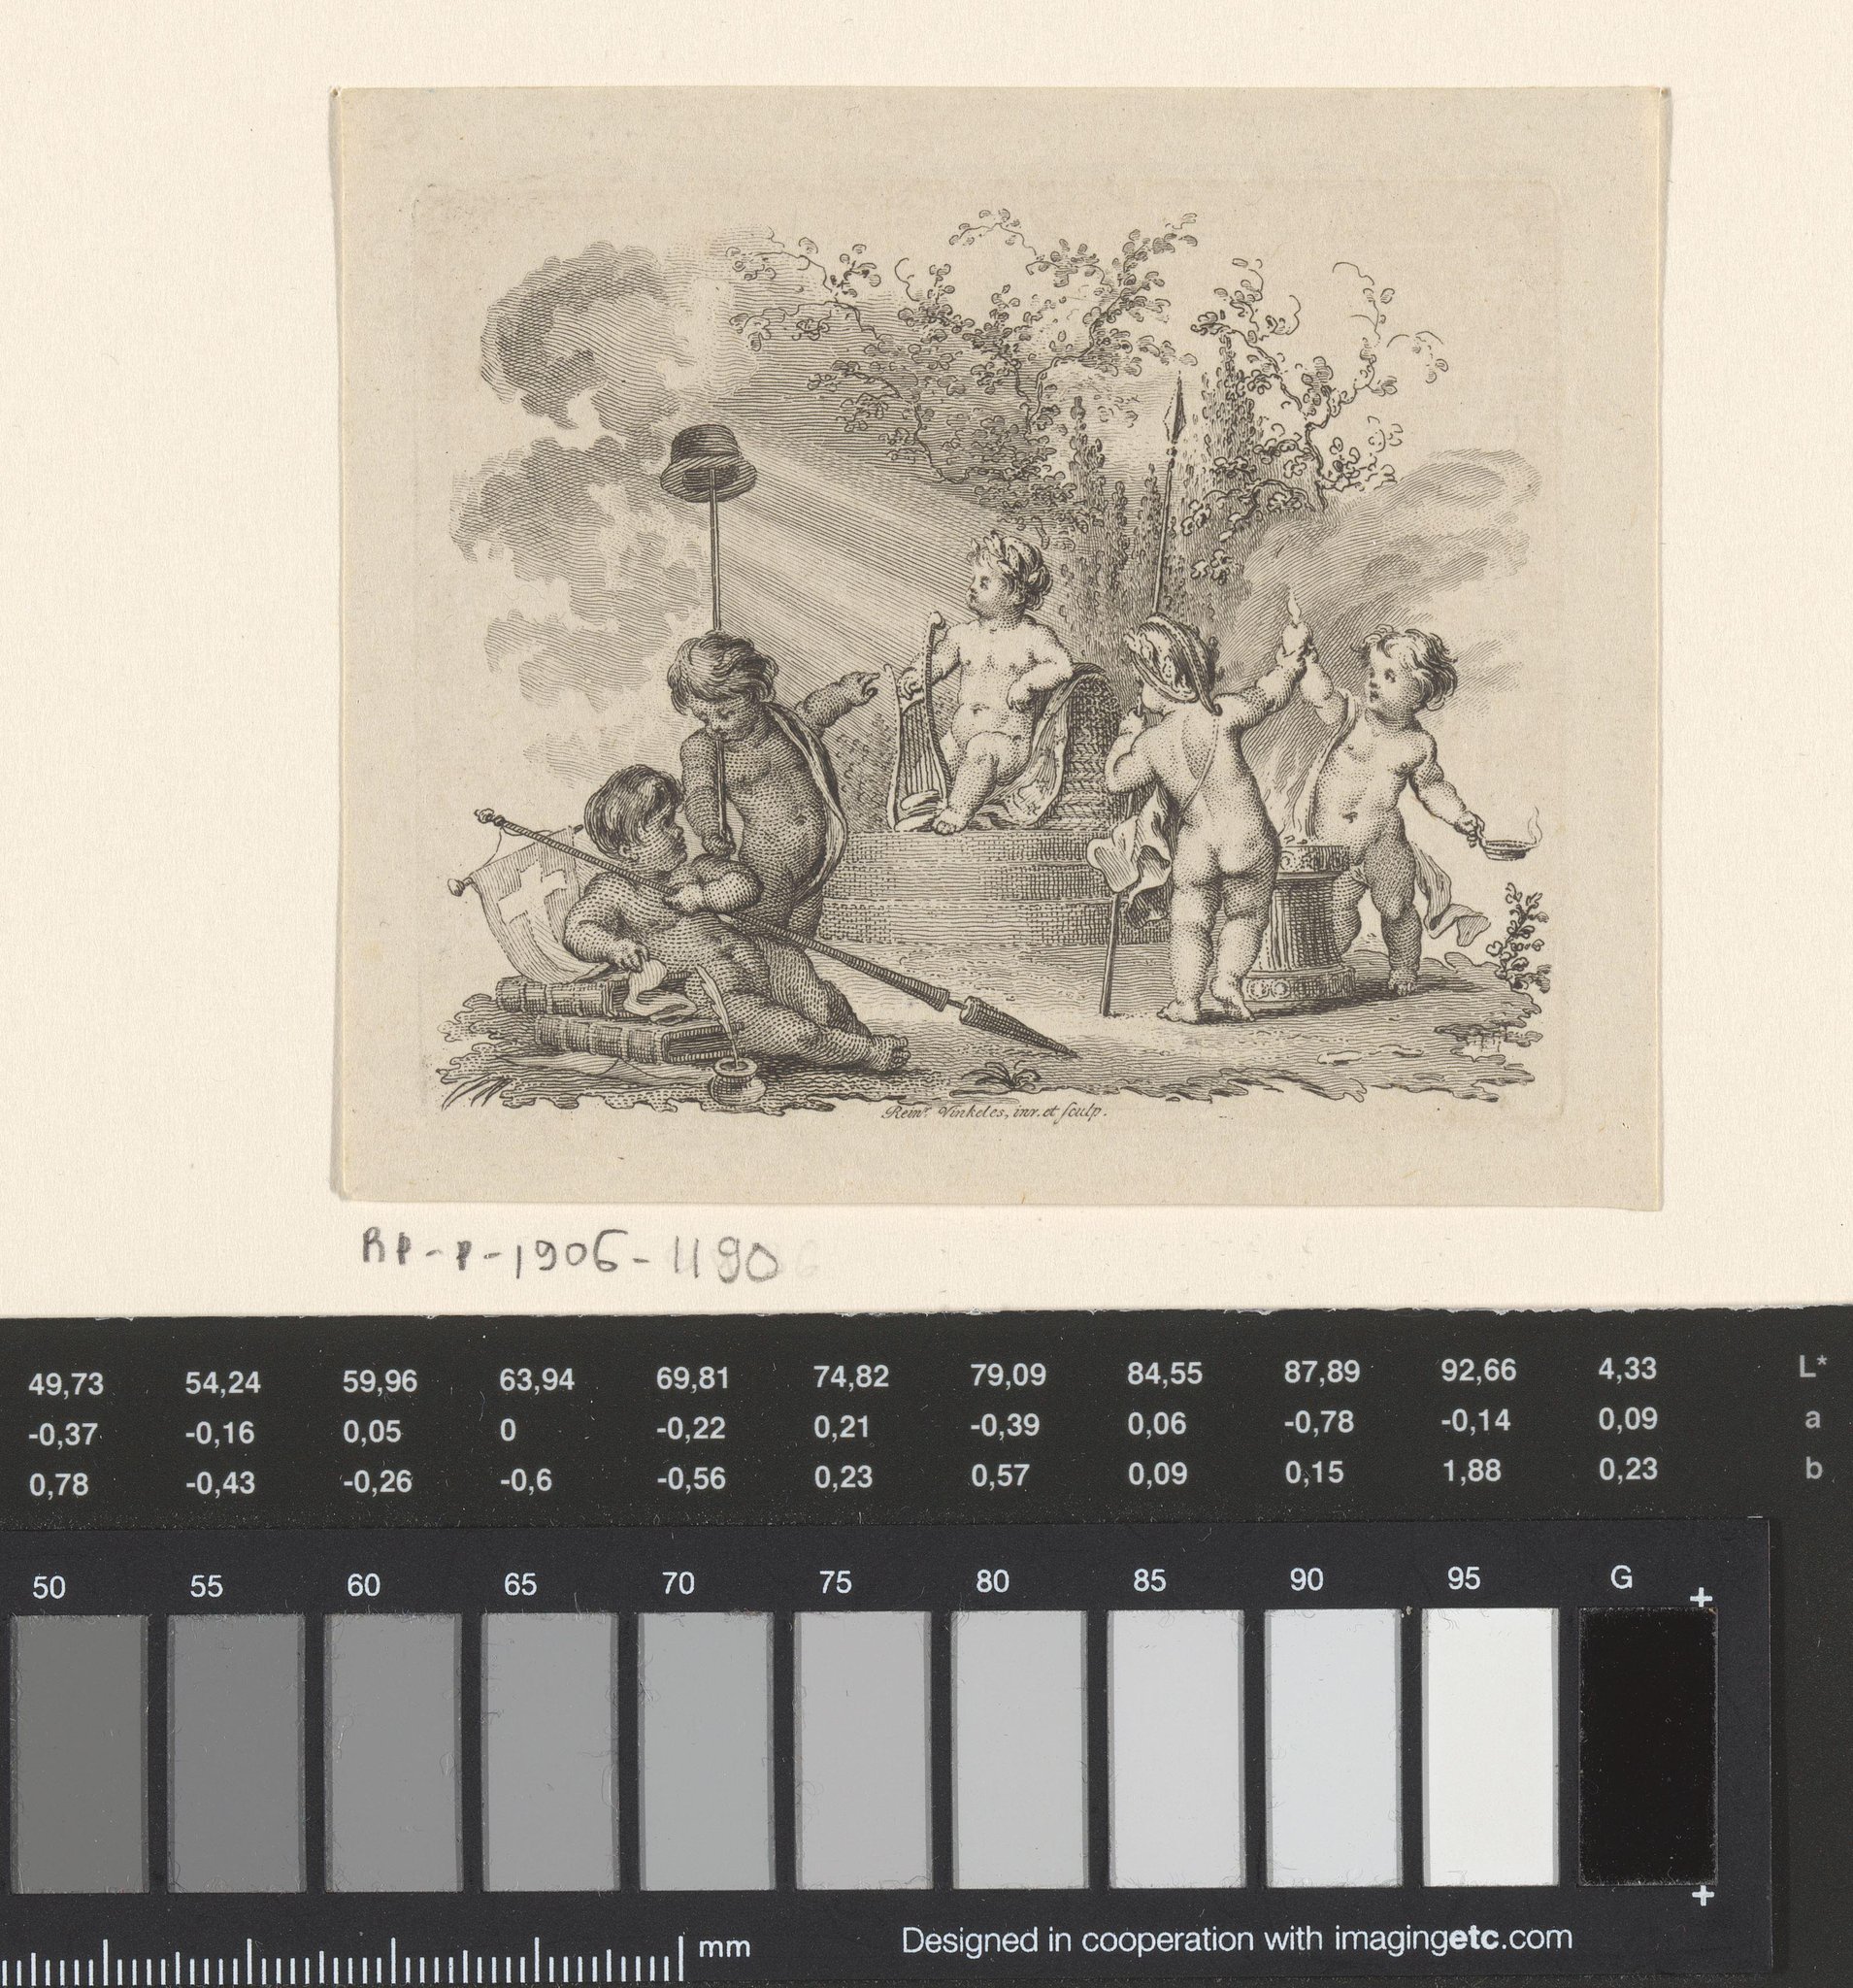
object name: print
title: Vijf putti met allegorische attributen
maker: reinier vinkeles (i)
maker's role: draughtsman, print maker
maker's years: 1741-1816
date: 1751-1816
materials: paper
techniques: engraving, etching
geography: amsterdam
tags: writing tools, bee-hive, freedom, liberty; 'libertà' (ripa) (+ symbolical representation of concept)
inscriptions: collector's mark: Lugt 2228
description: Landschap met putti met allegorische attributen, zoals de vredeshoed, schrijfgerei, een harp en een bijenkorf.